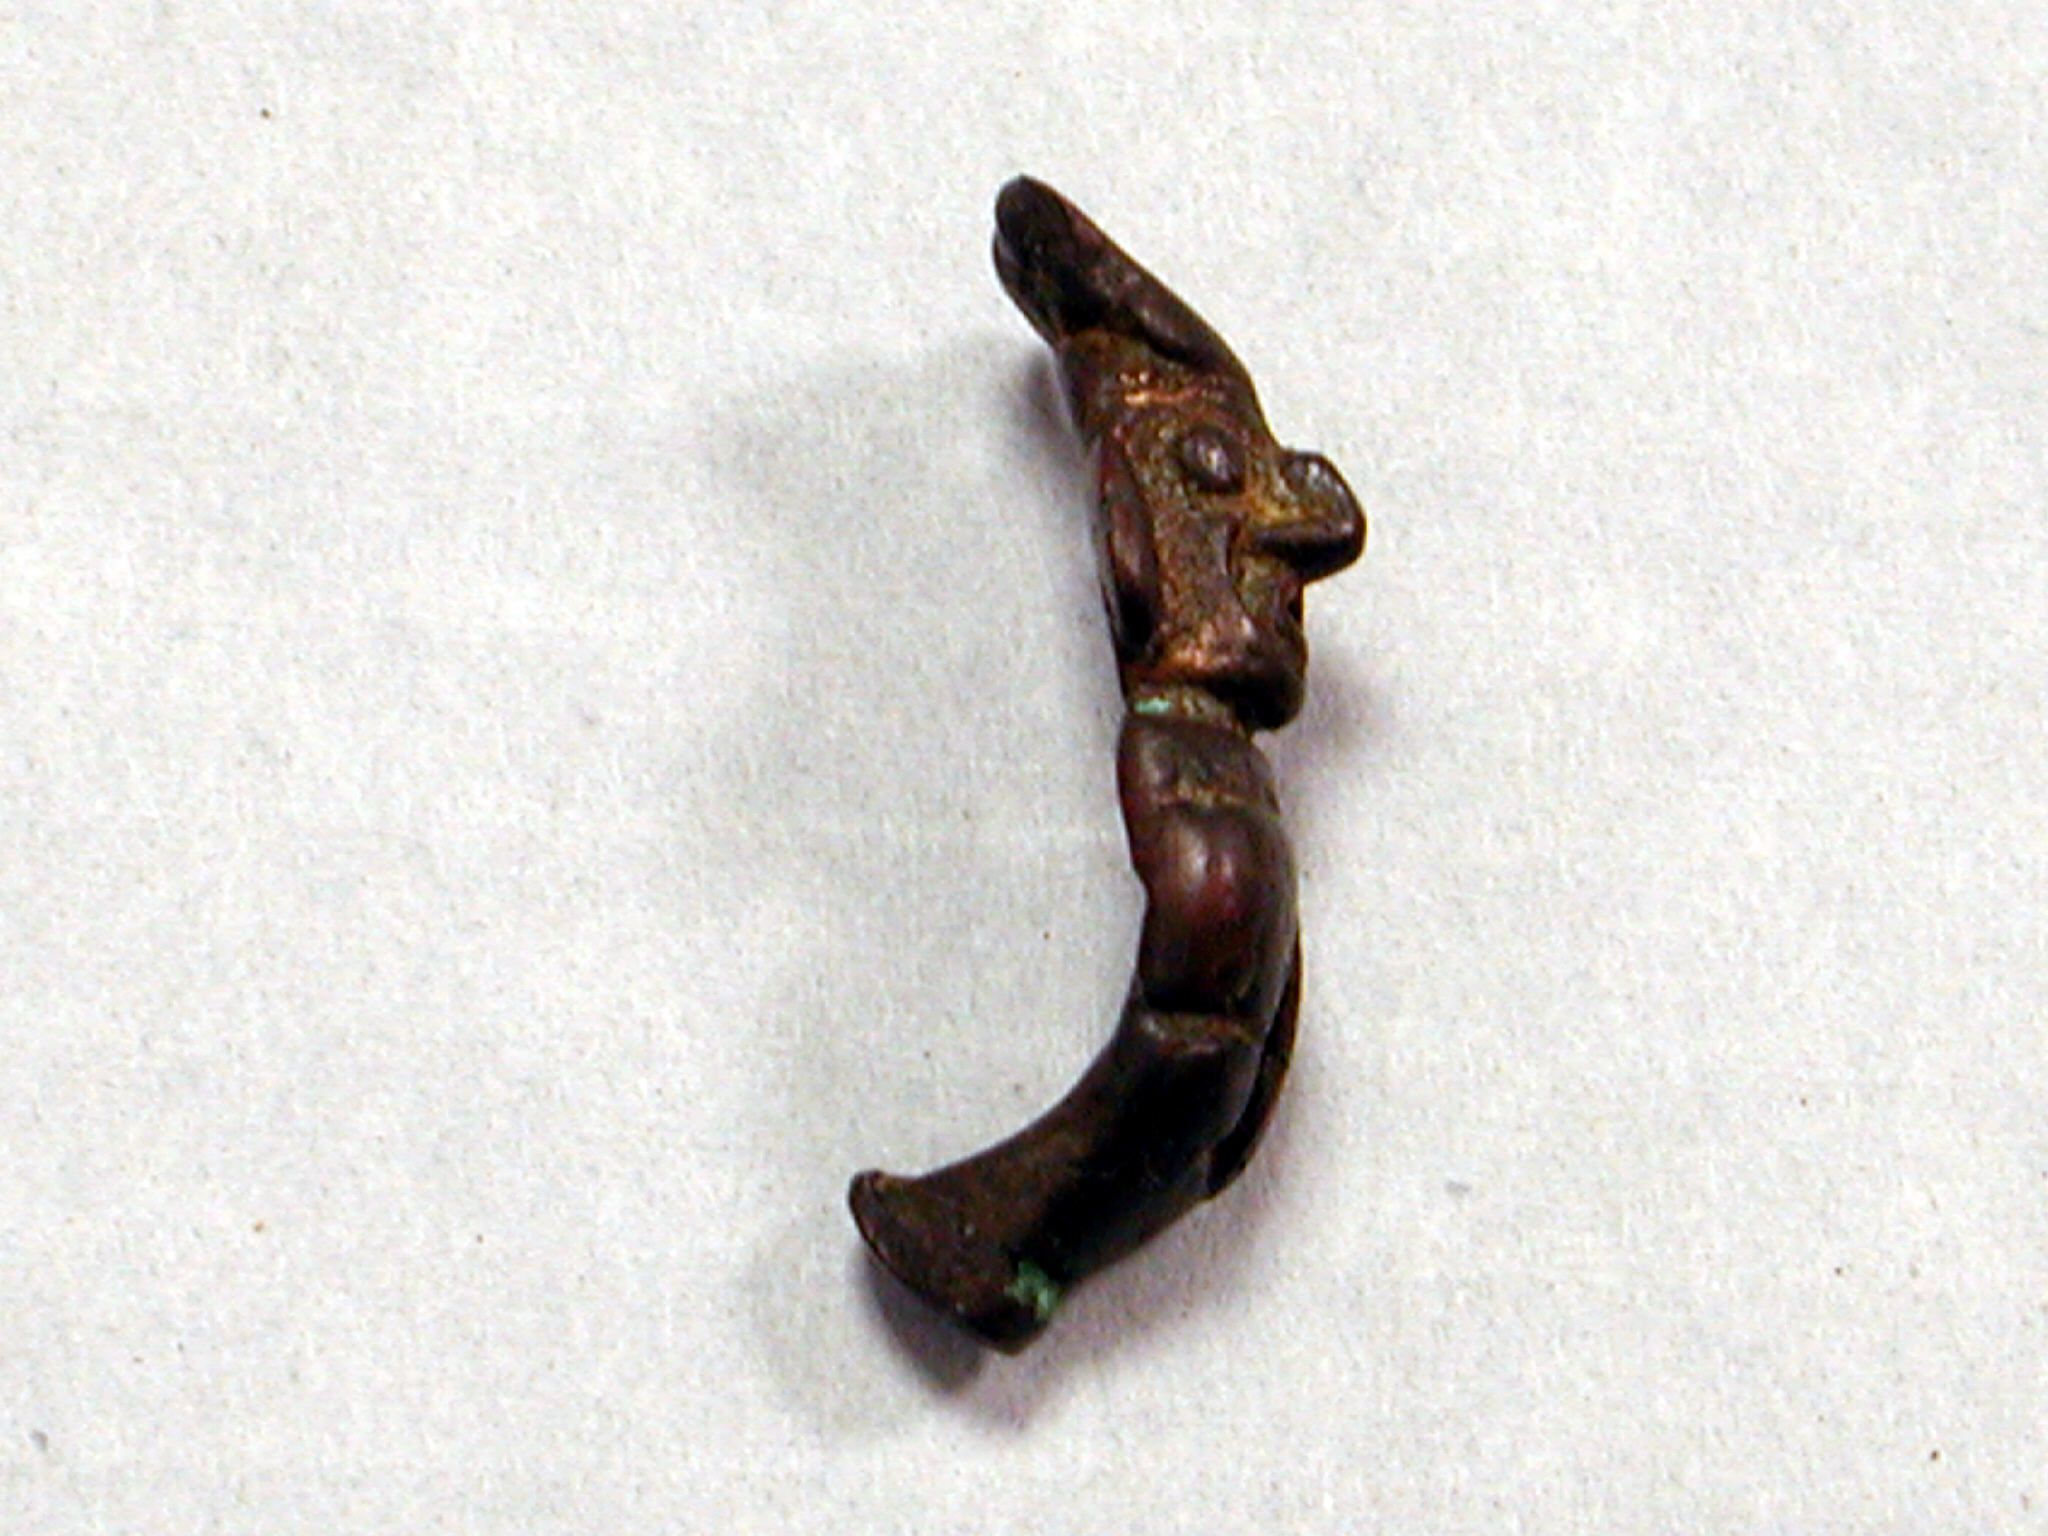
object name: spear thrower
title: Copper Atlatl Spear Thrower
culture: inca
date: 1401-1600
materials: copper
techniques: casting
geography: peru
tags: weapons